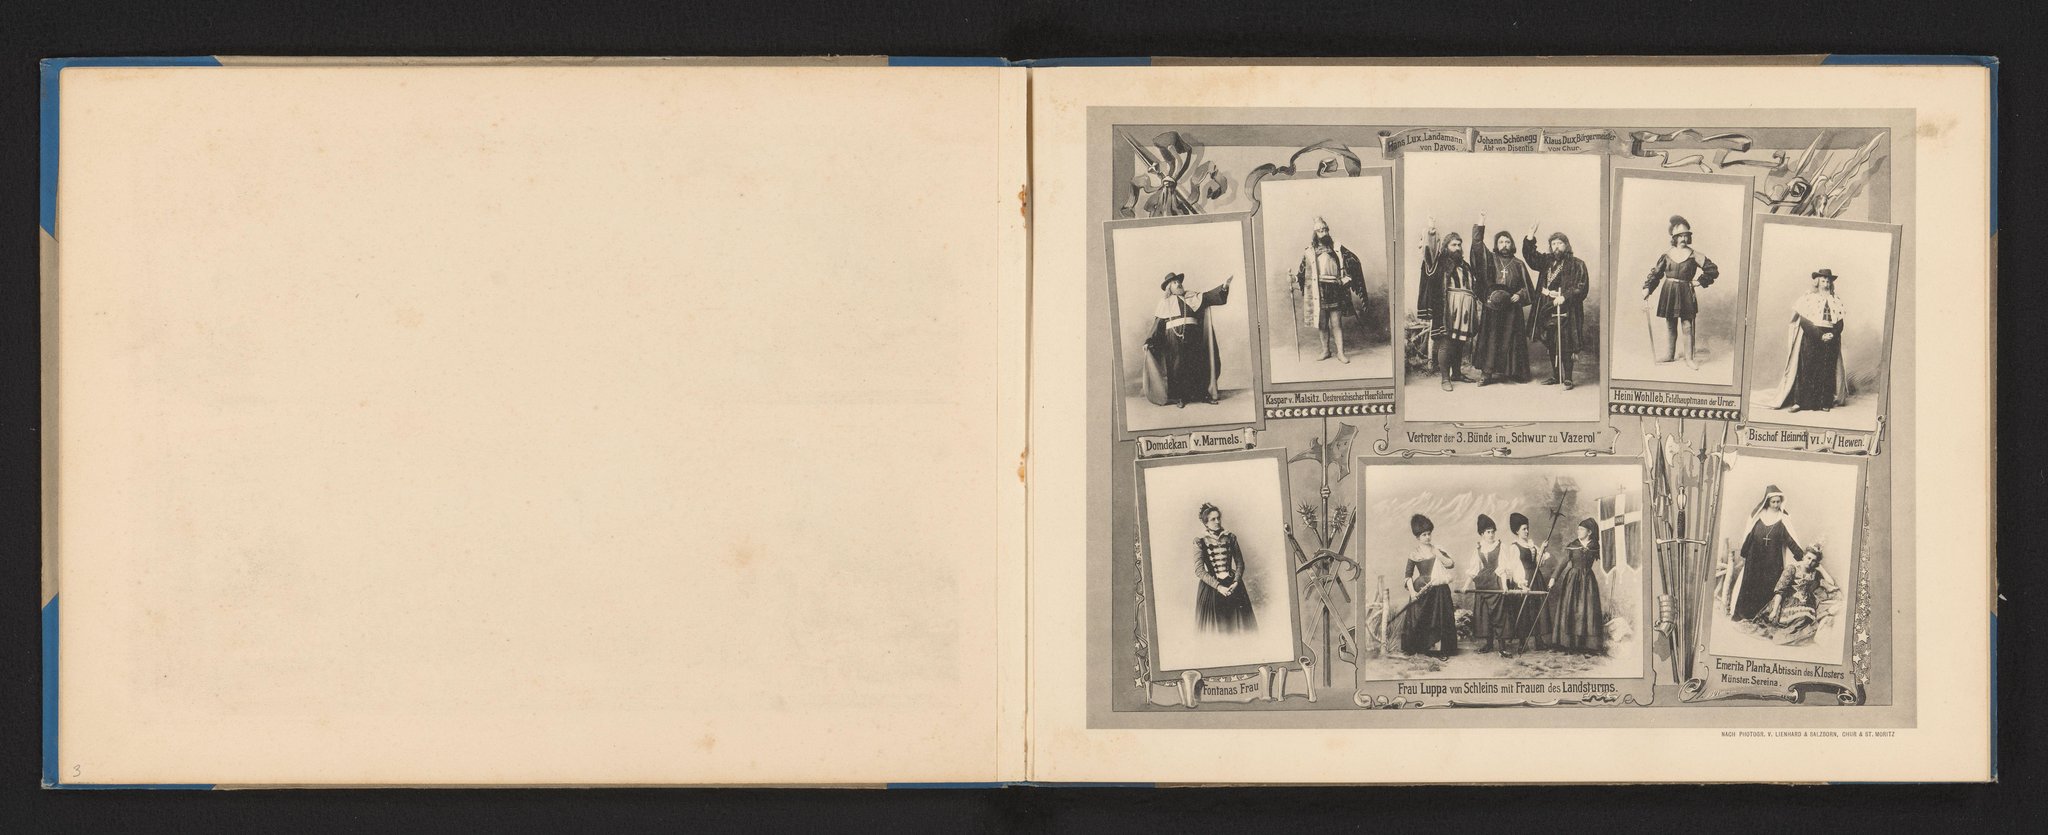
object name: montagefoto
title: Samengesteld groepsportret van toneelspelers in kostuum tijdens de Calven-Feier te Chur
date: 1898-1899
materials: paper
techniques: photograph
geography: chur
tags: group of actors, troupe; actors on the stage